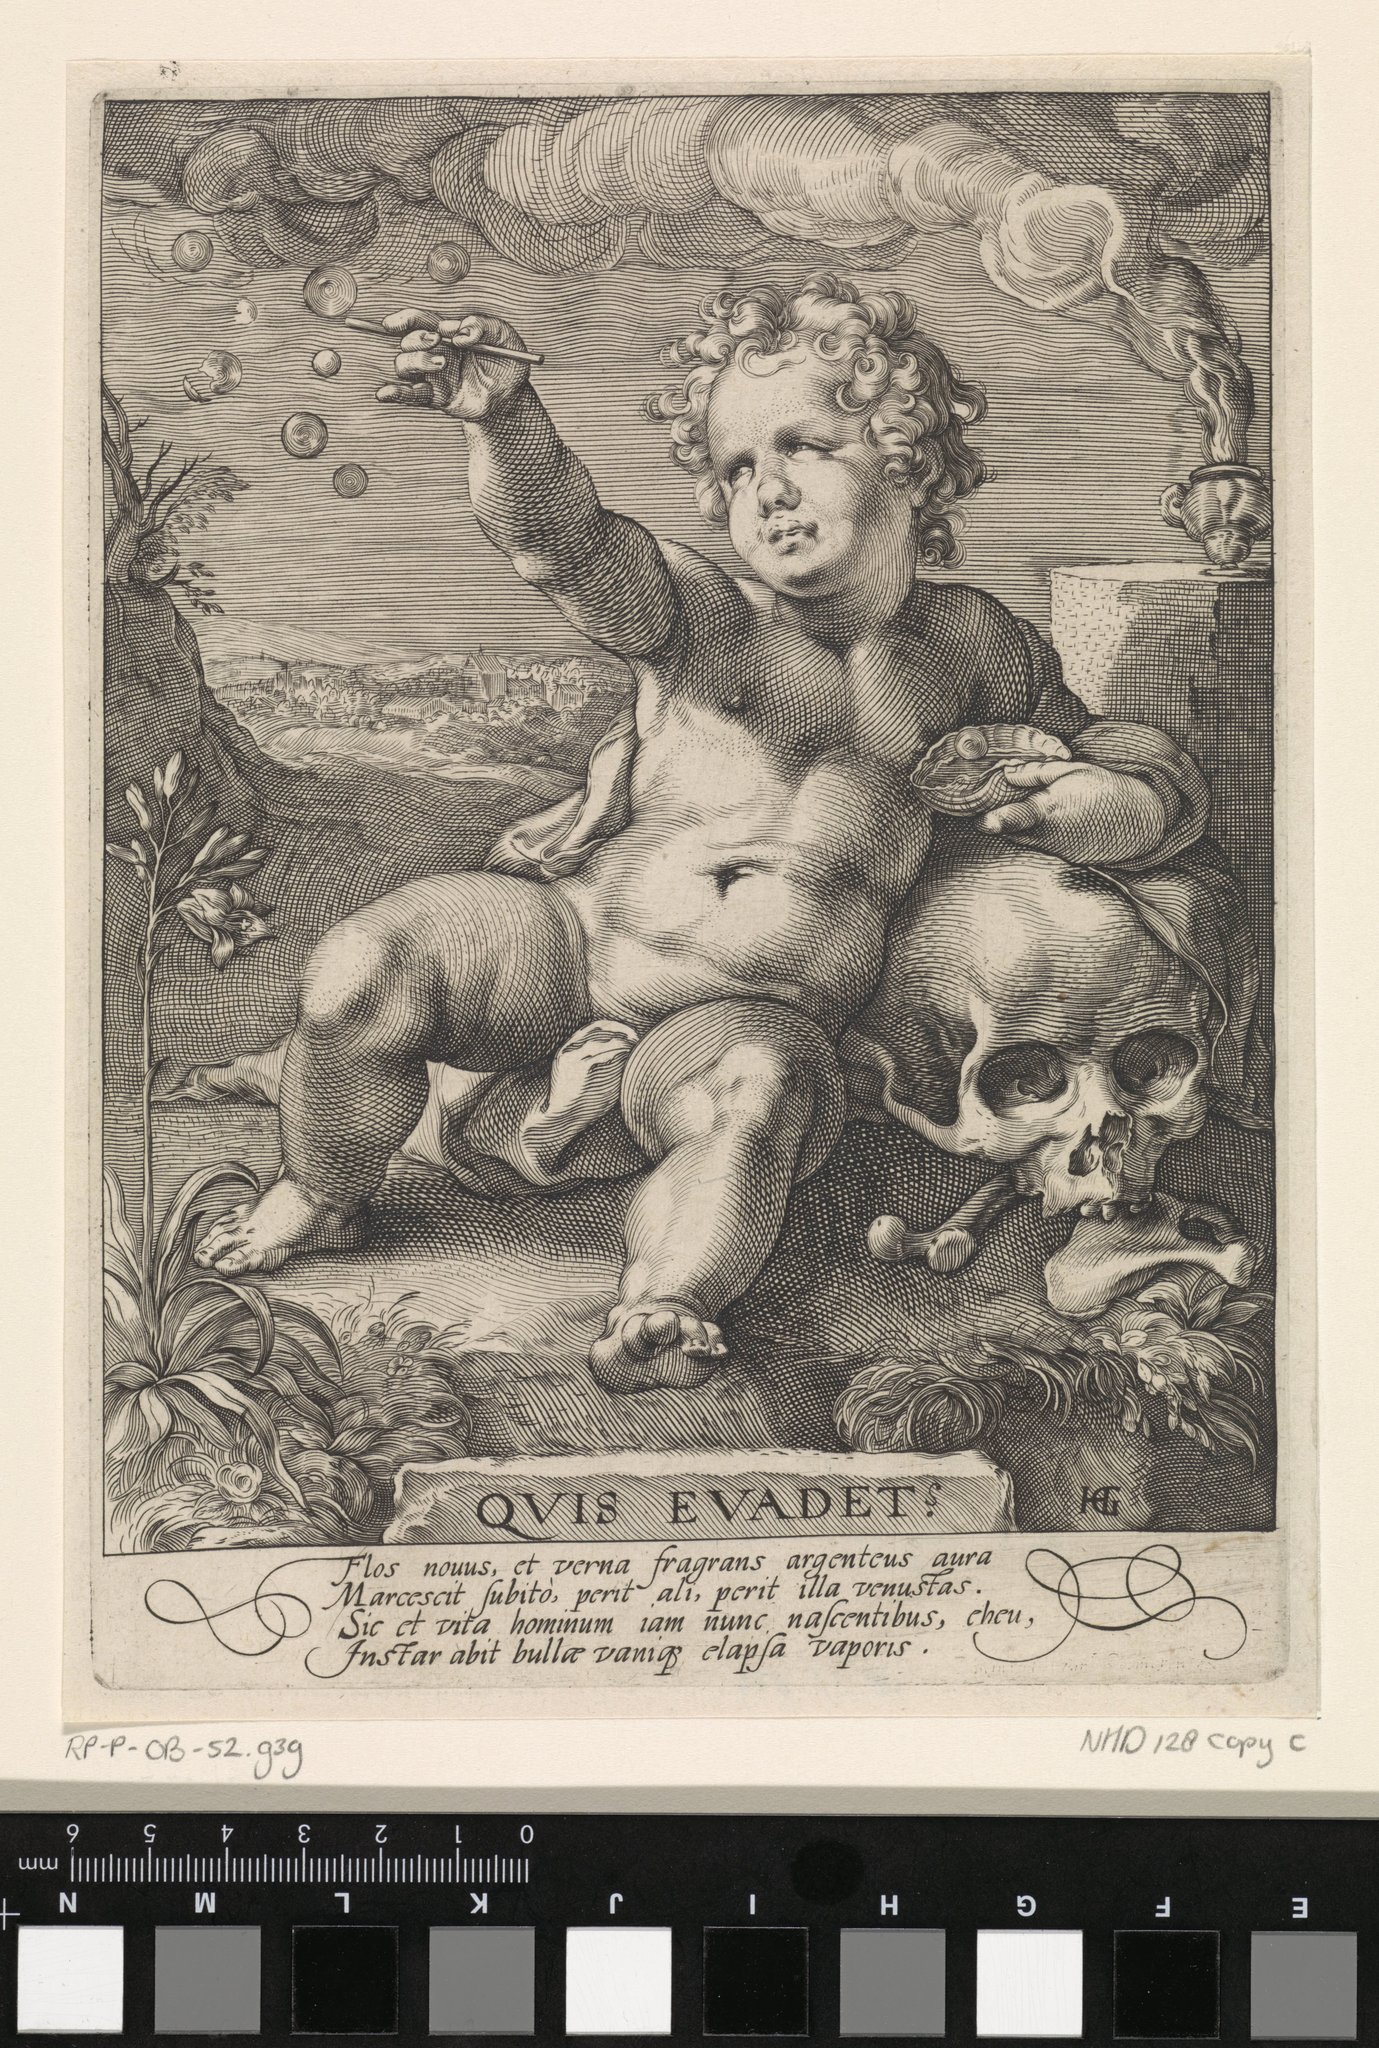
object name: print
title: Allegory of Transience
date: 1594-1667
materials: paper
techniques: engraving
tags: (children or putti) blowing bubbles, 'homo bulla' ~ scene symbolizing 'vanitas'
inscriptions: collector's mark: Lugt 240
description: Een putto zit op de grond en leunt tegen een schedel, terwijl hij in zijn rechterhand een pijpje houdt waarmee hij bellen heeft geblazen. In zijn linkerhand houdt hij een schelp, Achter hem wierrookvat waaruit rook opstijgt. Onder de voorstelling een vierregelige tekst in het Latijn.